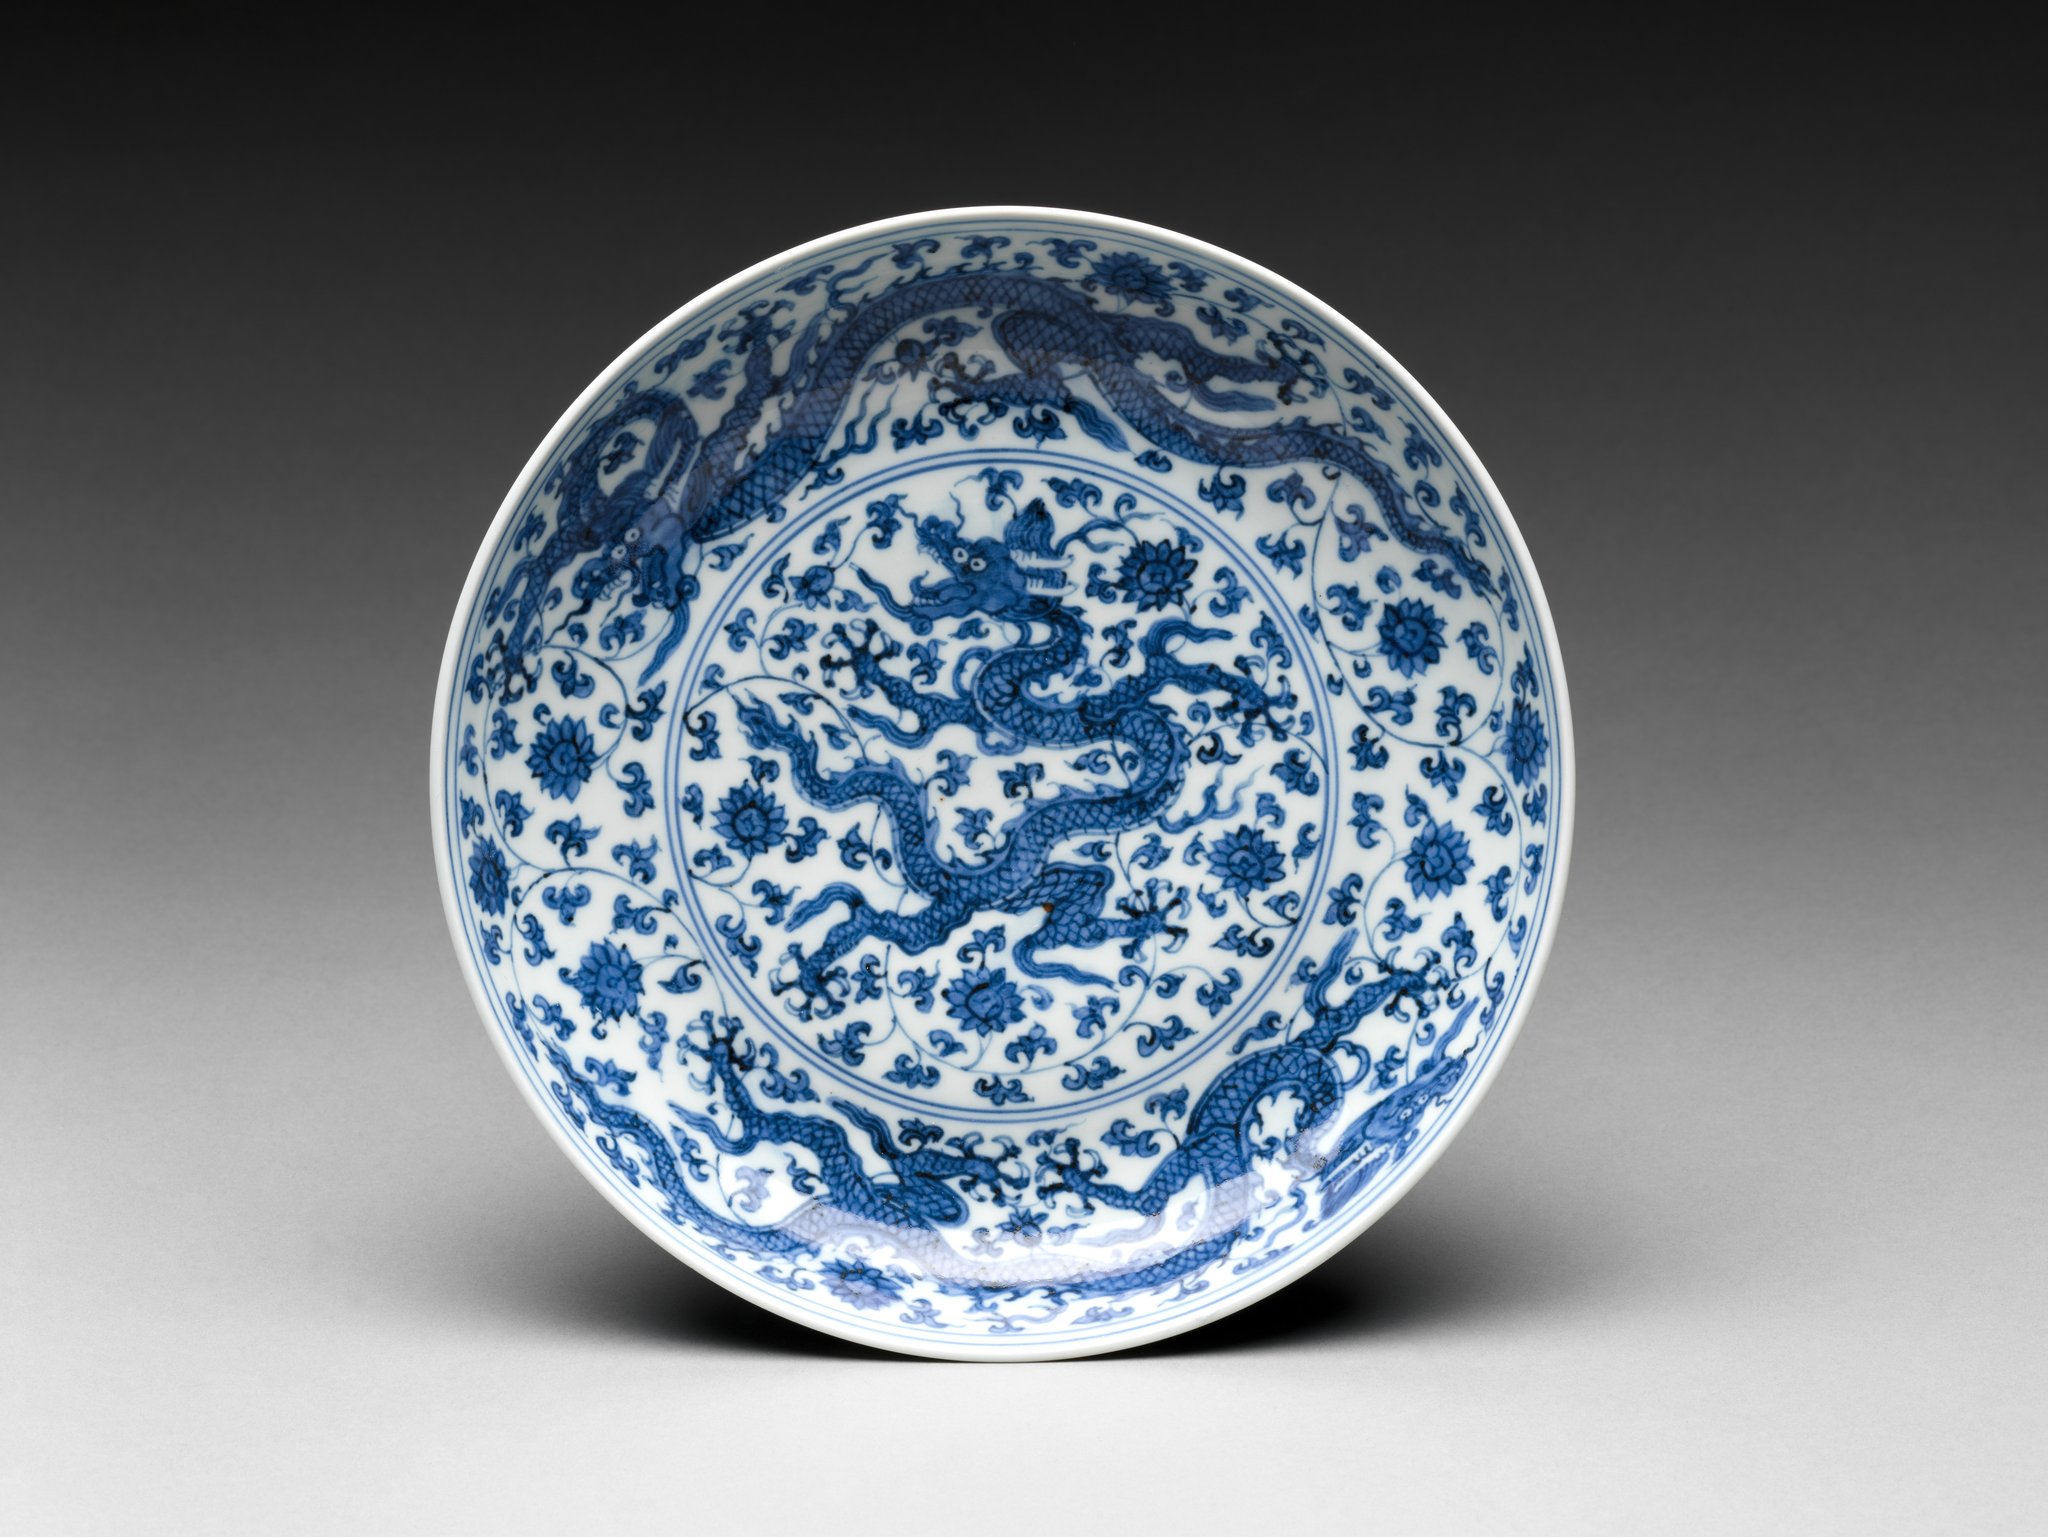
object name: dish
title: Dish with Dragons and Lotuses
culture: chinese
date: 1501-1533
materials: cobalt, glaze, porcelain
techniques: painting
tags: dragons,lotuses